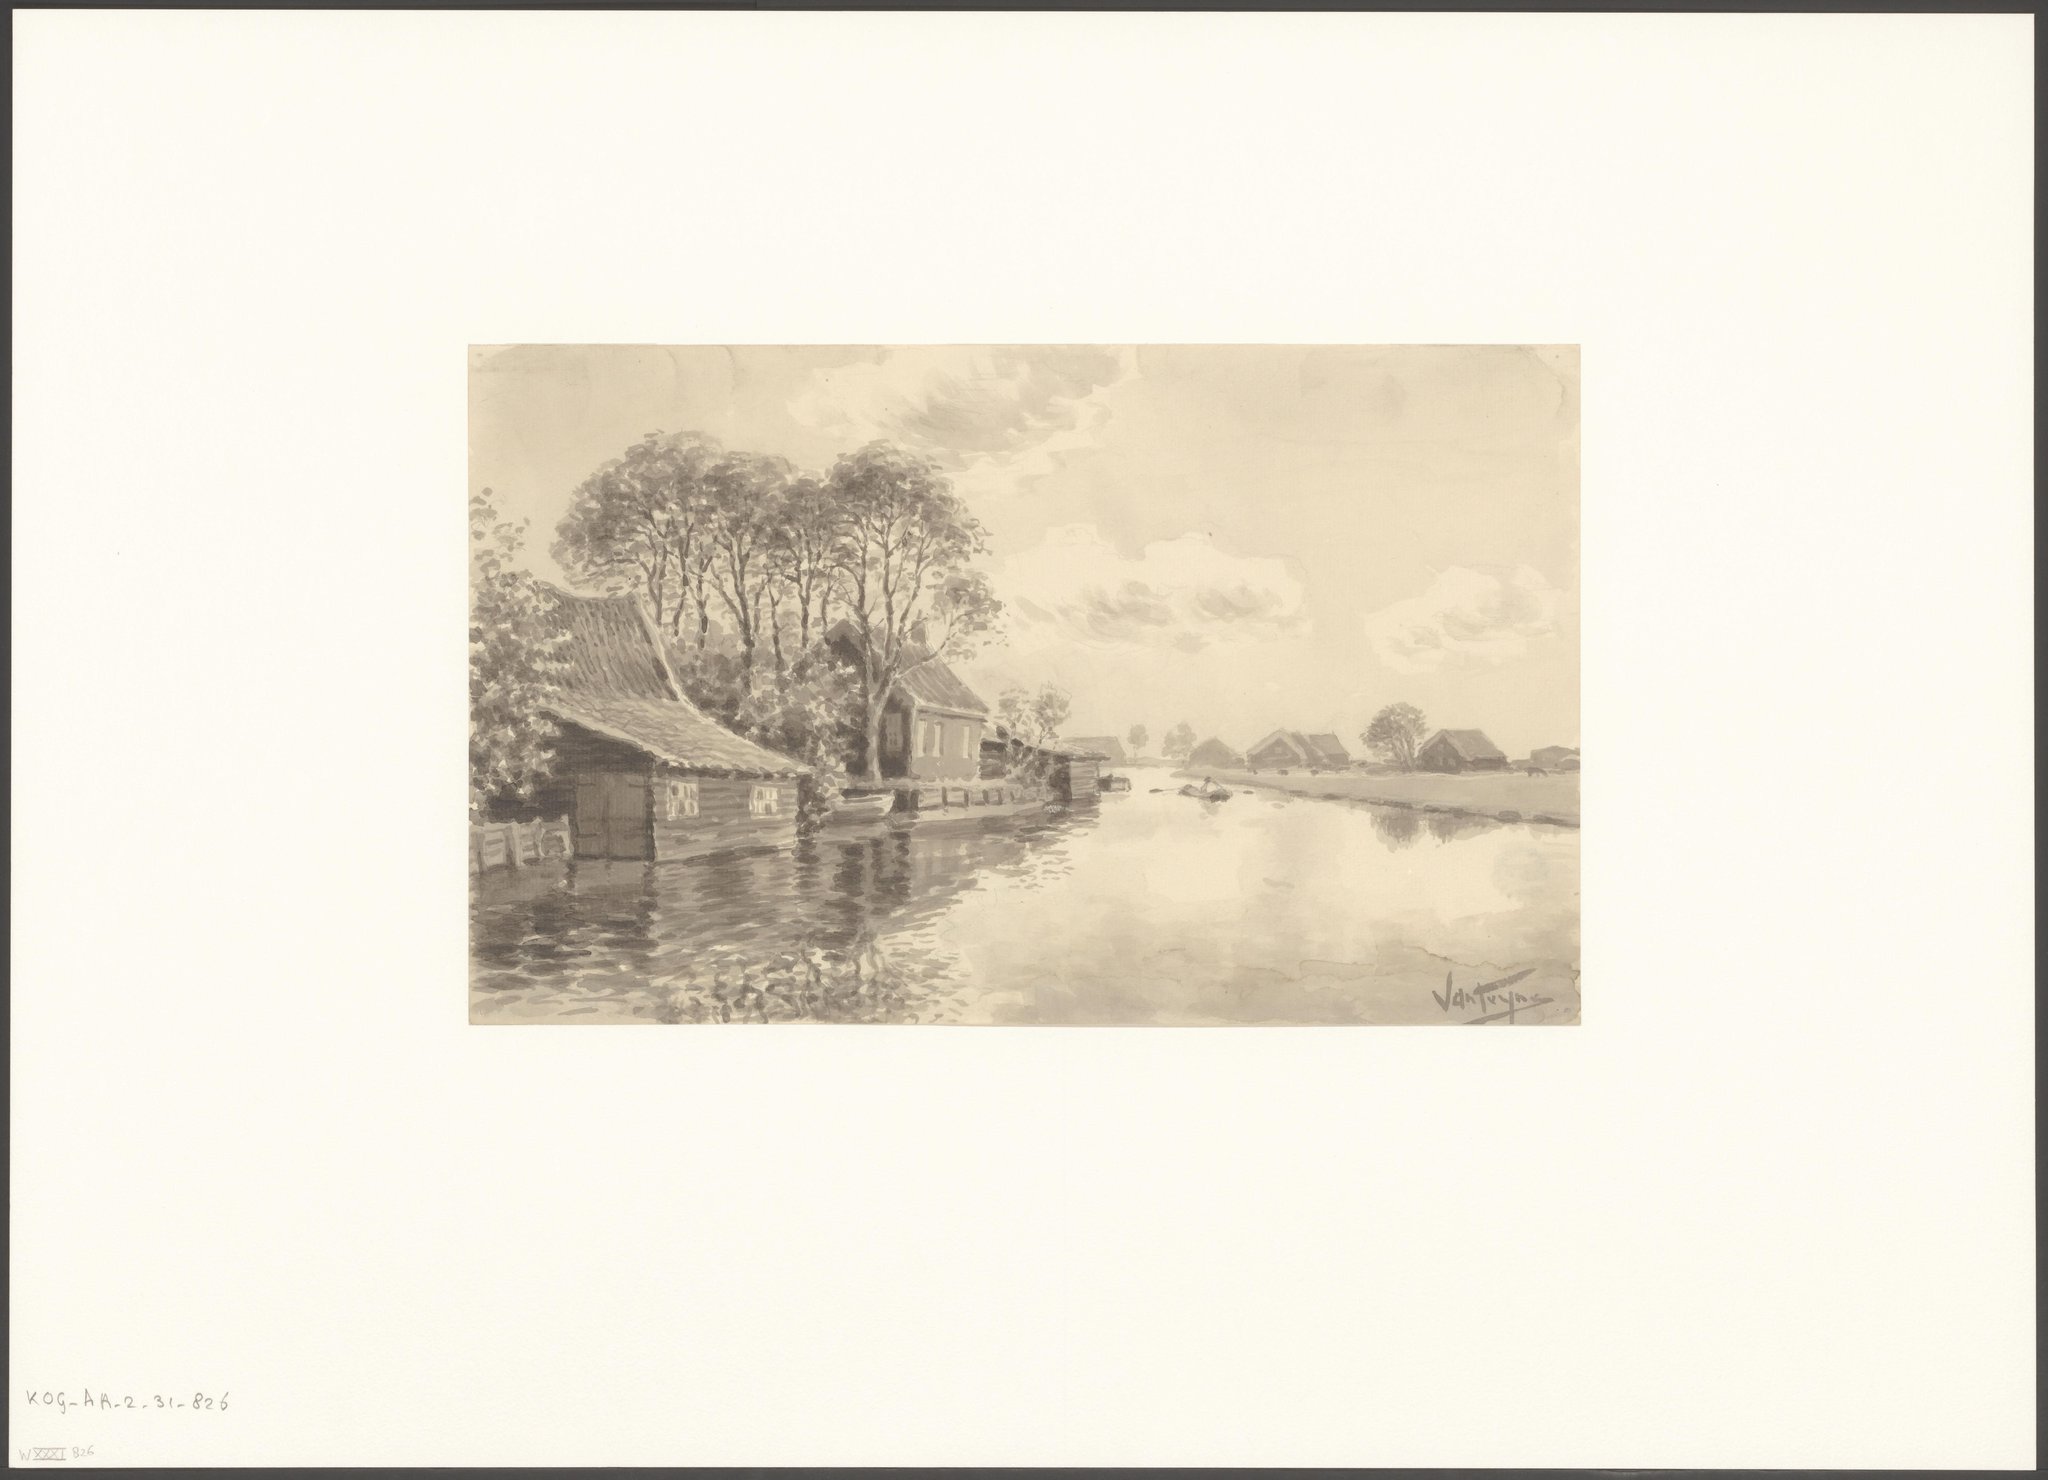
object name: drawing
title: Gezicht op de Slotervaart vanaf het Surinameplein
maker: anthonie van teijn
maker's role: draughtsman, painter, print maker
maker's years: 1863-1943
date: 1909-1927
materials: ink, paper, pencil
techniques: brush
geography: amsterdam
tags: city-view in general; 'veduta', canal, boat propelled by man or animal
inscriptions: collector's mark: Lugt 800a, signature: ‘VanTeyne’, inscription: ‘De Slotervaart gezien (...) Sept. 1927. / vanEck’, inscription: ‘Bij de Jacob Marisstraat’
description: Tekening binnen de Atlas Van Eck ingedeeld op wijknummer 31.